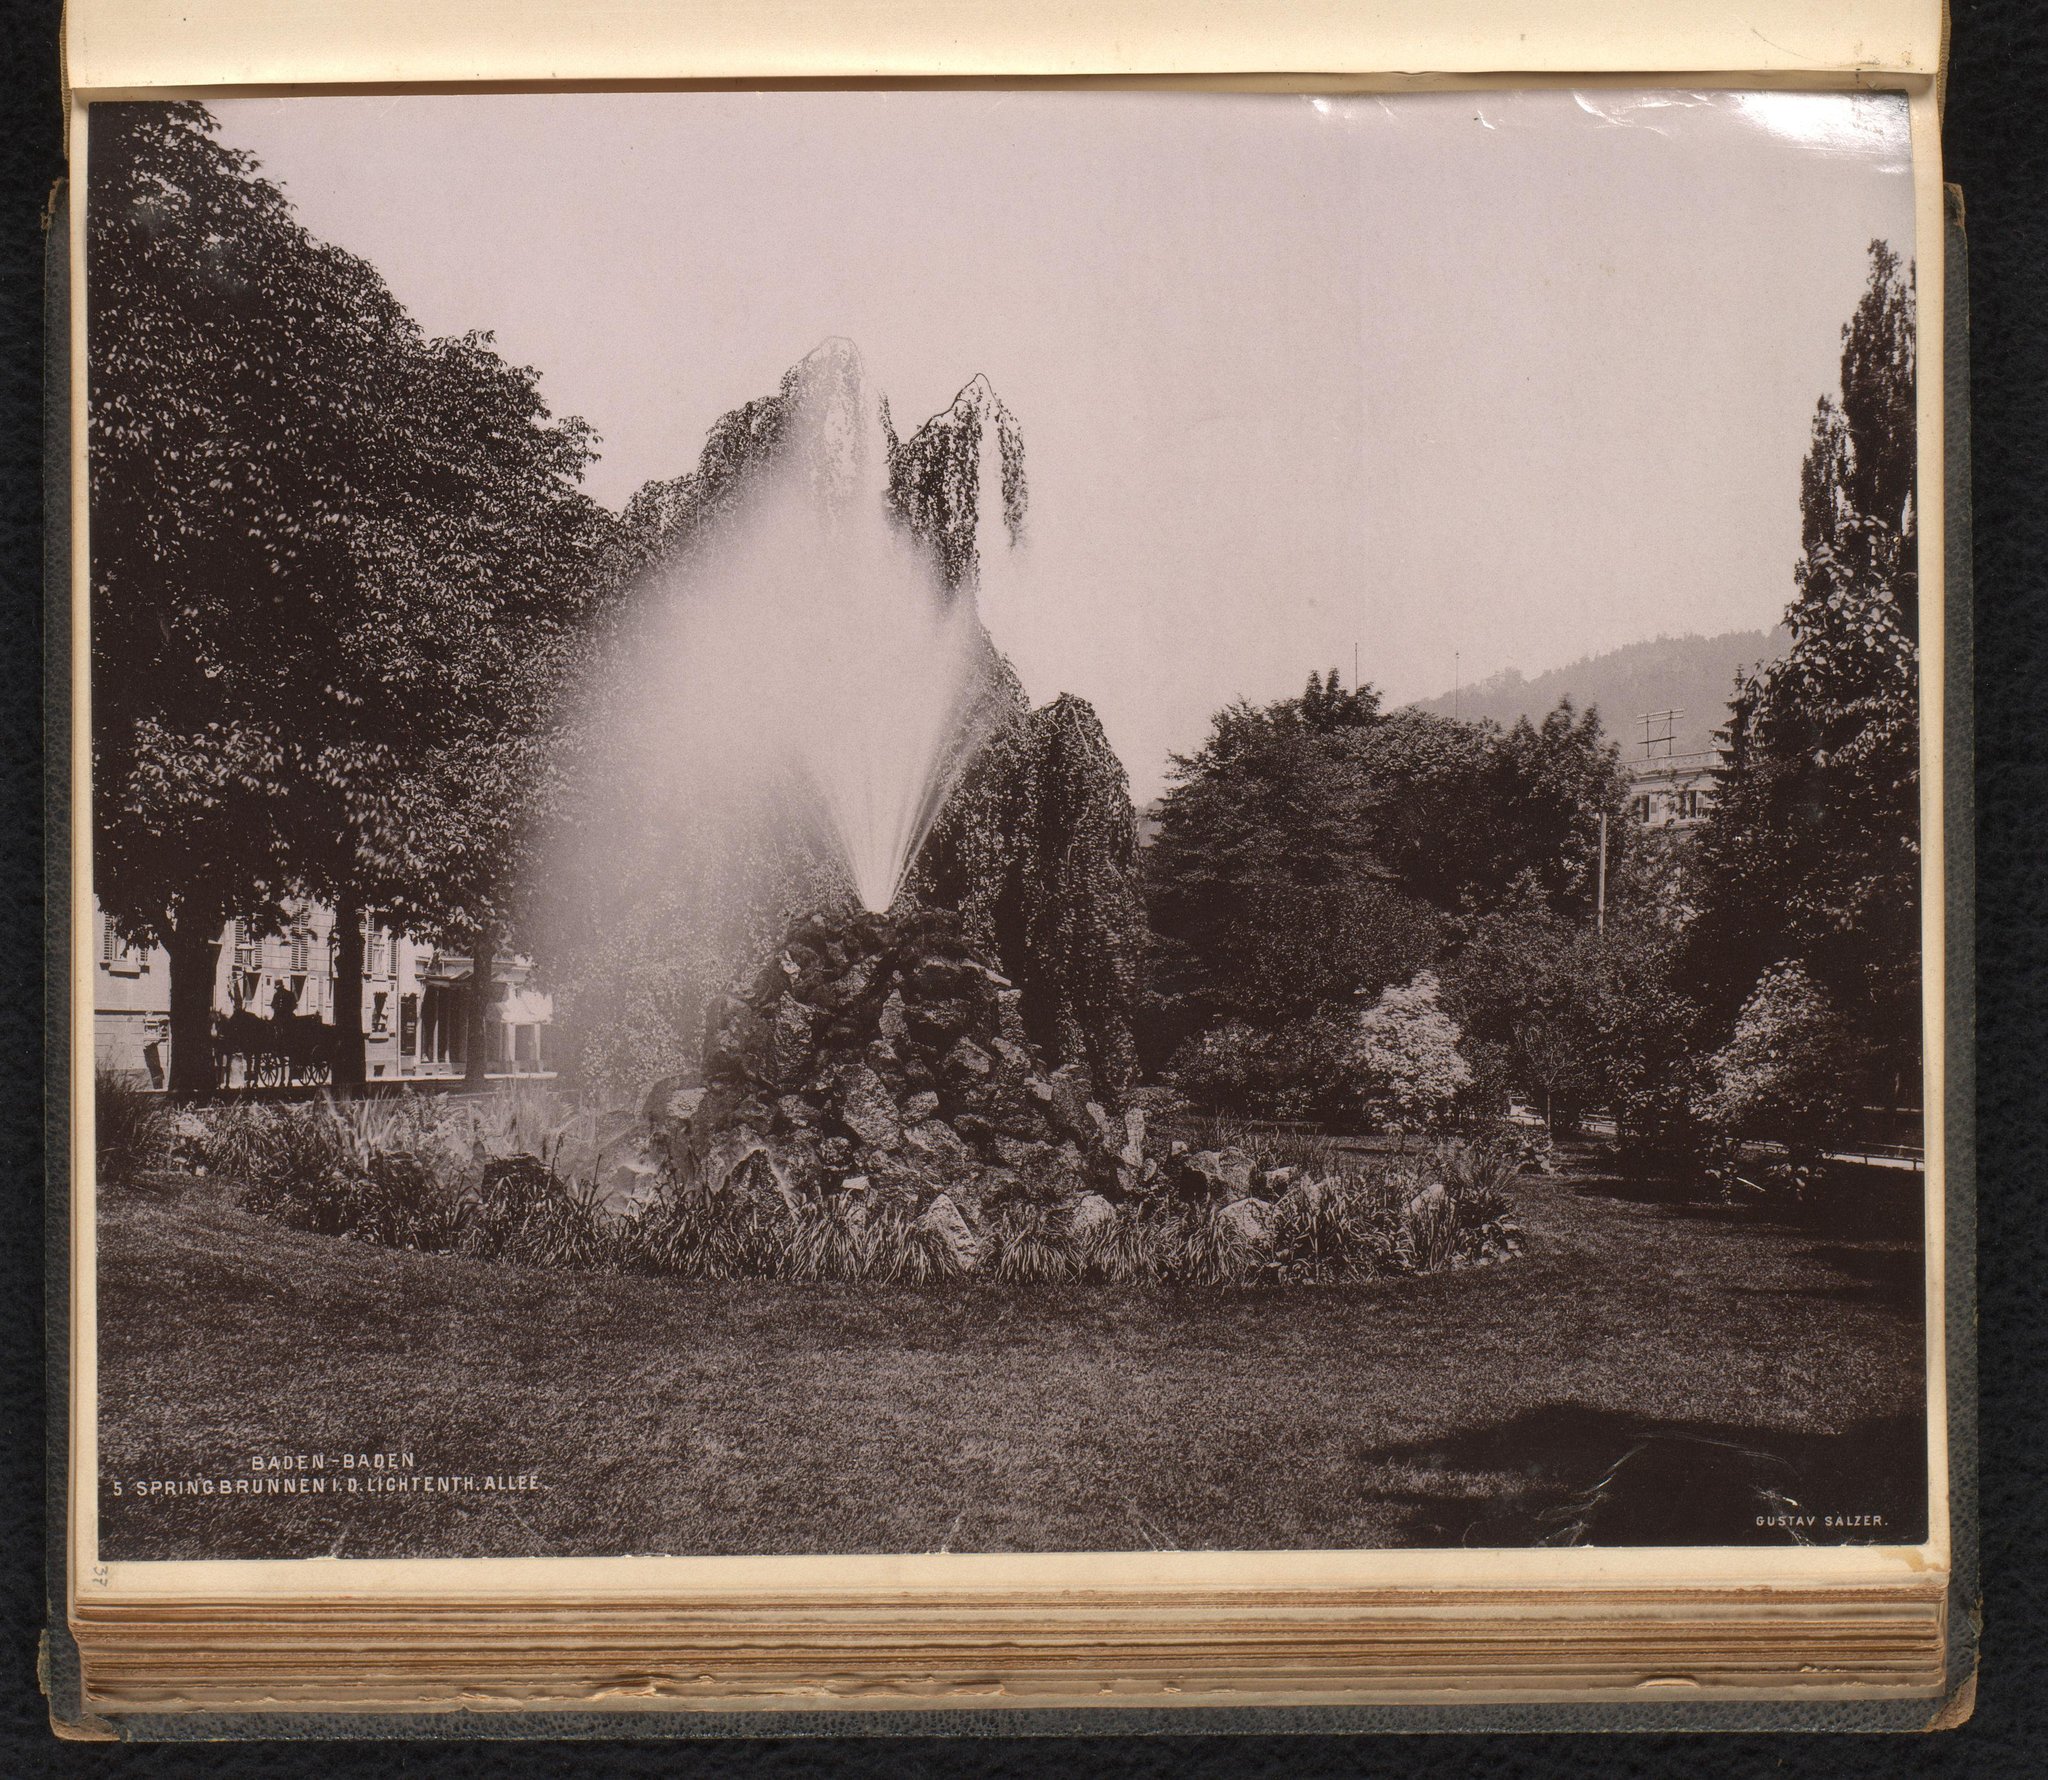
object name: photomechanical print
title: Fontein in Baden-Baden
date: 1897-1903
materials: paper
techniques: photograph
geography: baden-baden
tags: ornamental fountain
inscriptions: number: ‘5’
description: Deze prent maakt deel uit van een album.